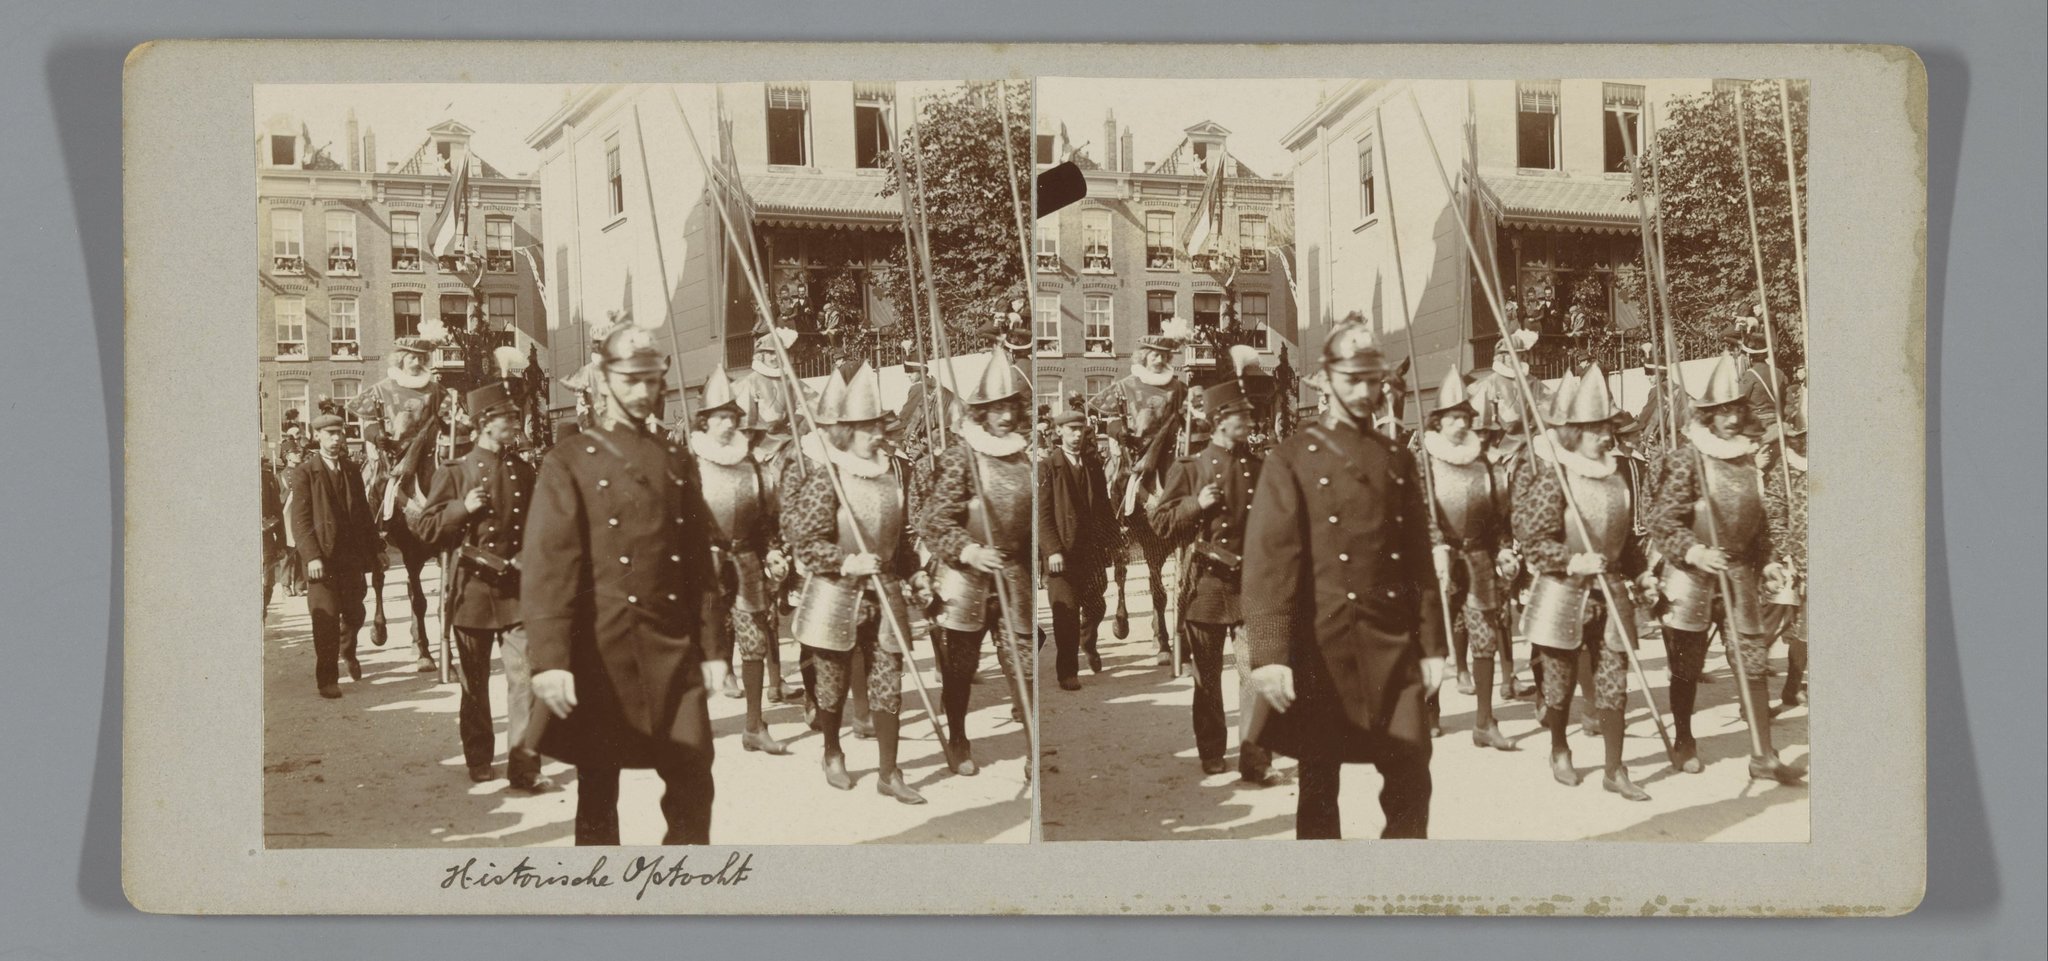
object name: stereograph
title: Historische optocht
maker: Anonymous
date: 1898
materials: paper, cardboard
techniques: gelatin silver print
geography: amsterdam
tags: print maker, wilhelmina of the netherlands, ceremonial celebration of installation of a ruler, amsterdam